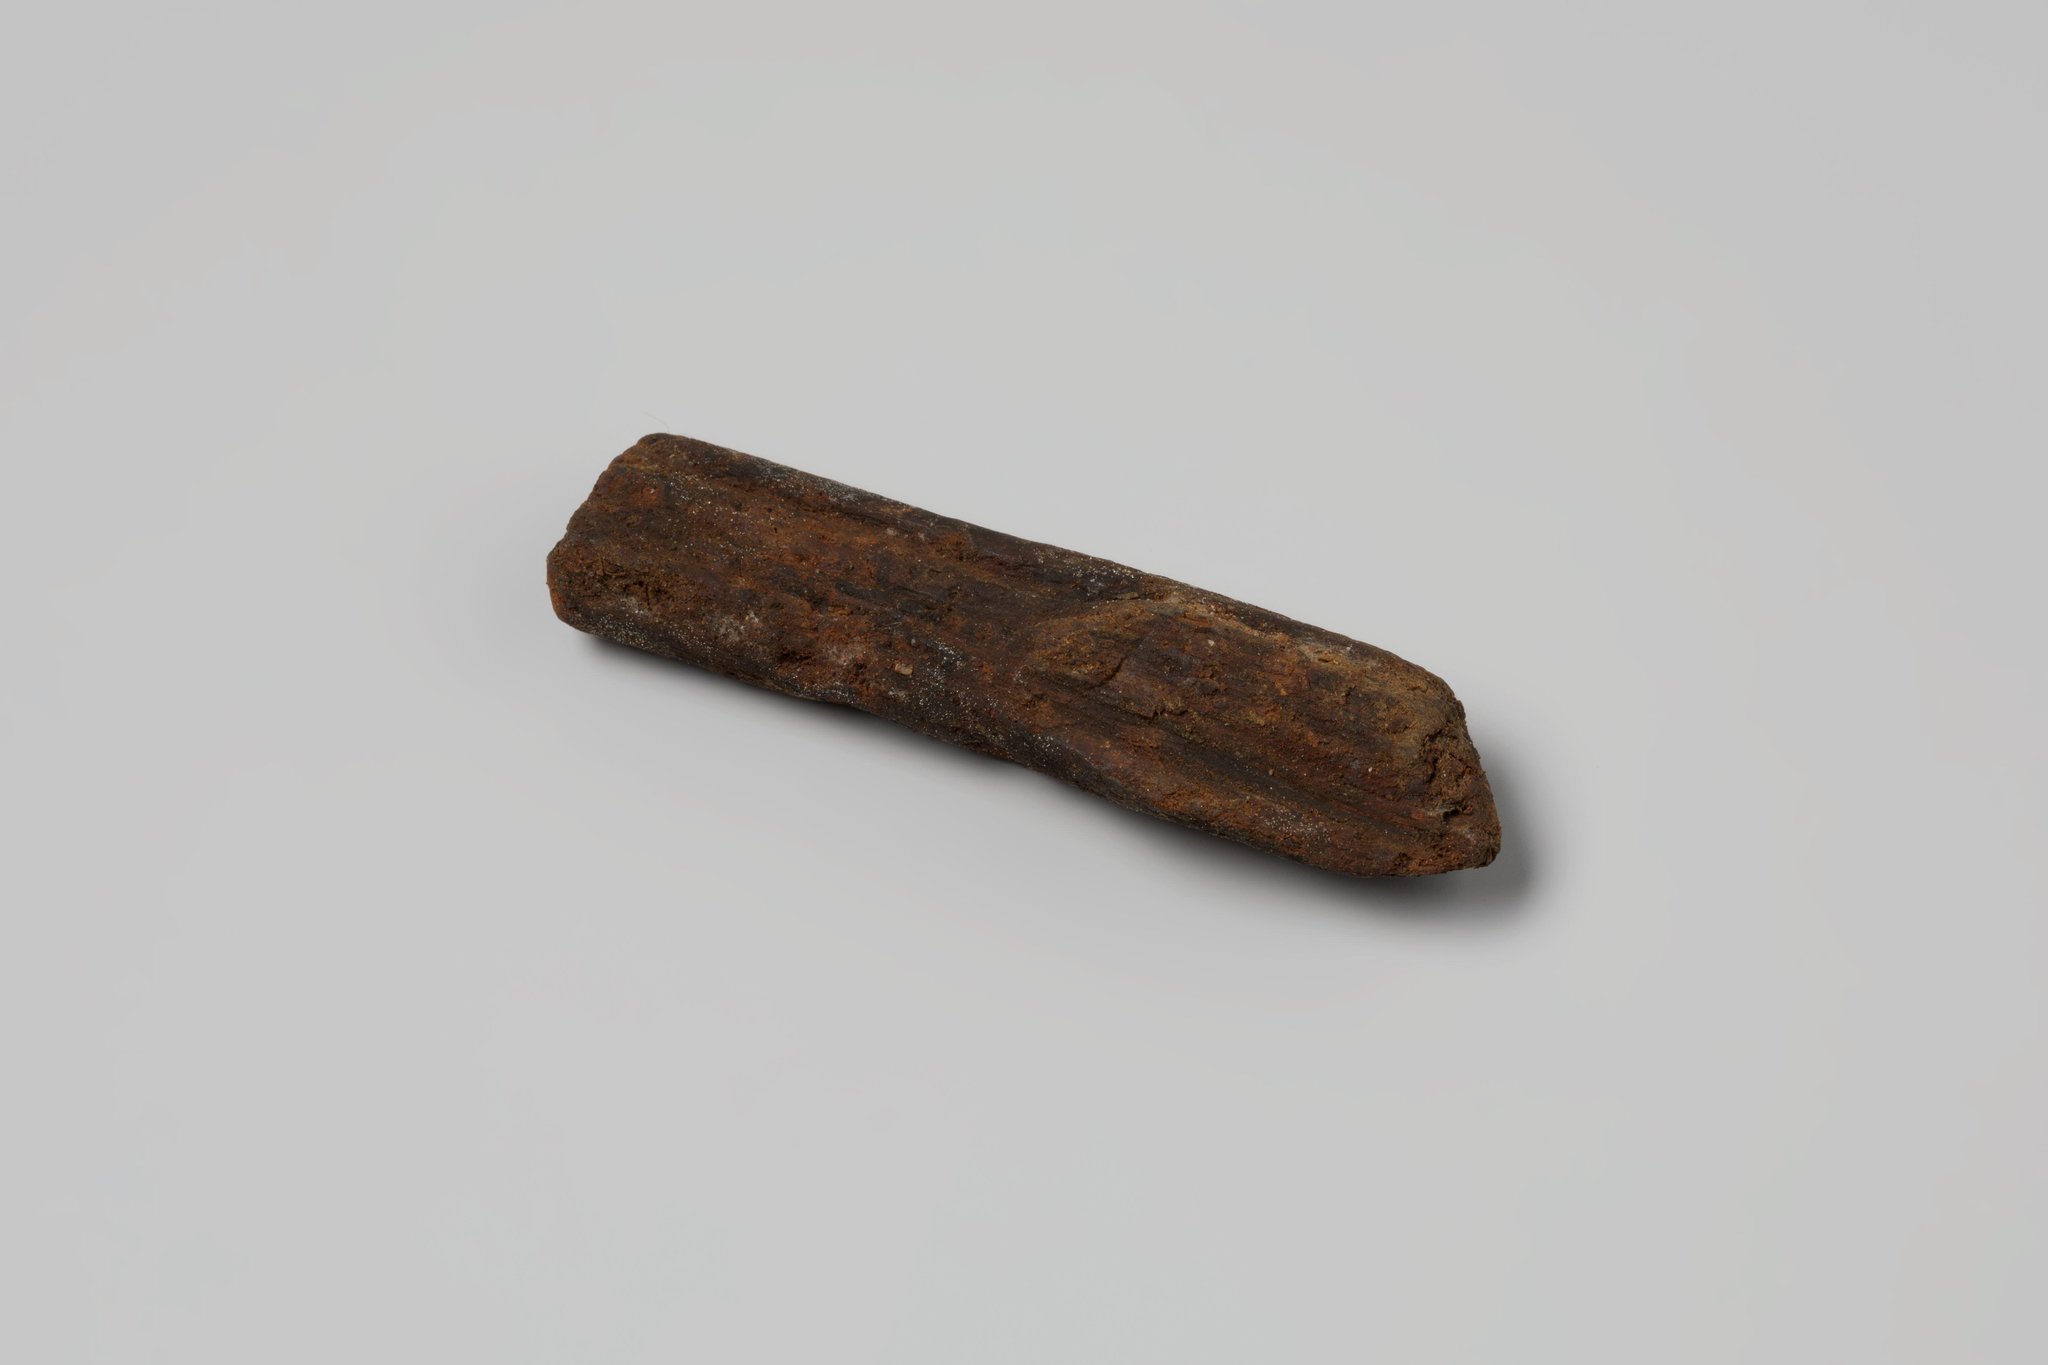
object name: knife handle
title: Messenheft uit het wrak van de Oost-Indiëvaarder Hollandia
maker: Anonymous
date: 1700-1743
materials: wood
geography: netherlands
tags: verenigde oostindische compagnie, hollandia (schip), annet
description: Knife, handle deformed: unclassifiable; slightly pistol-grip-shaped.